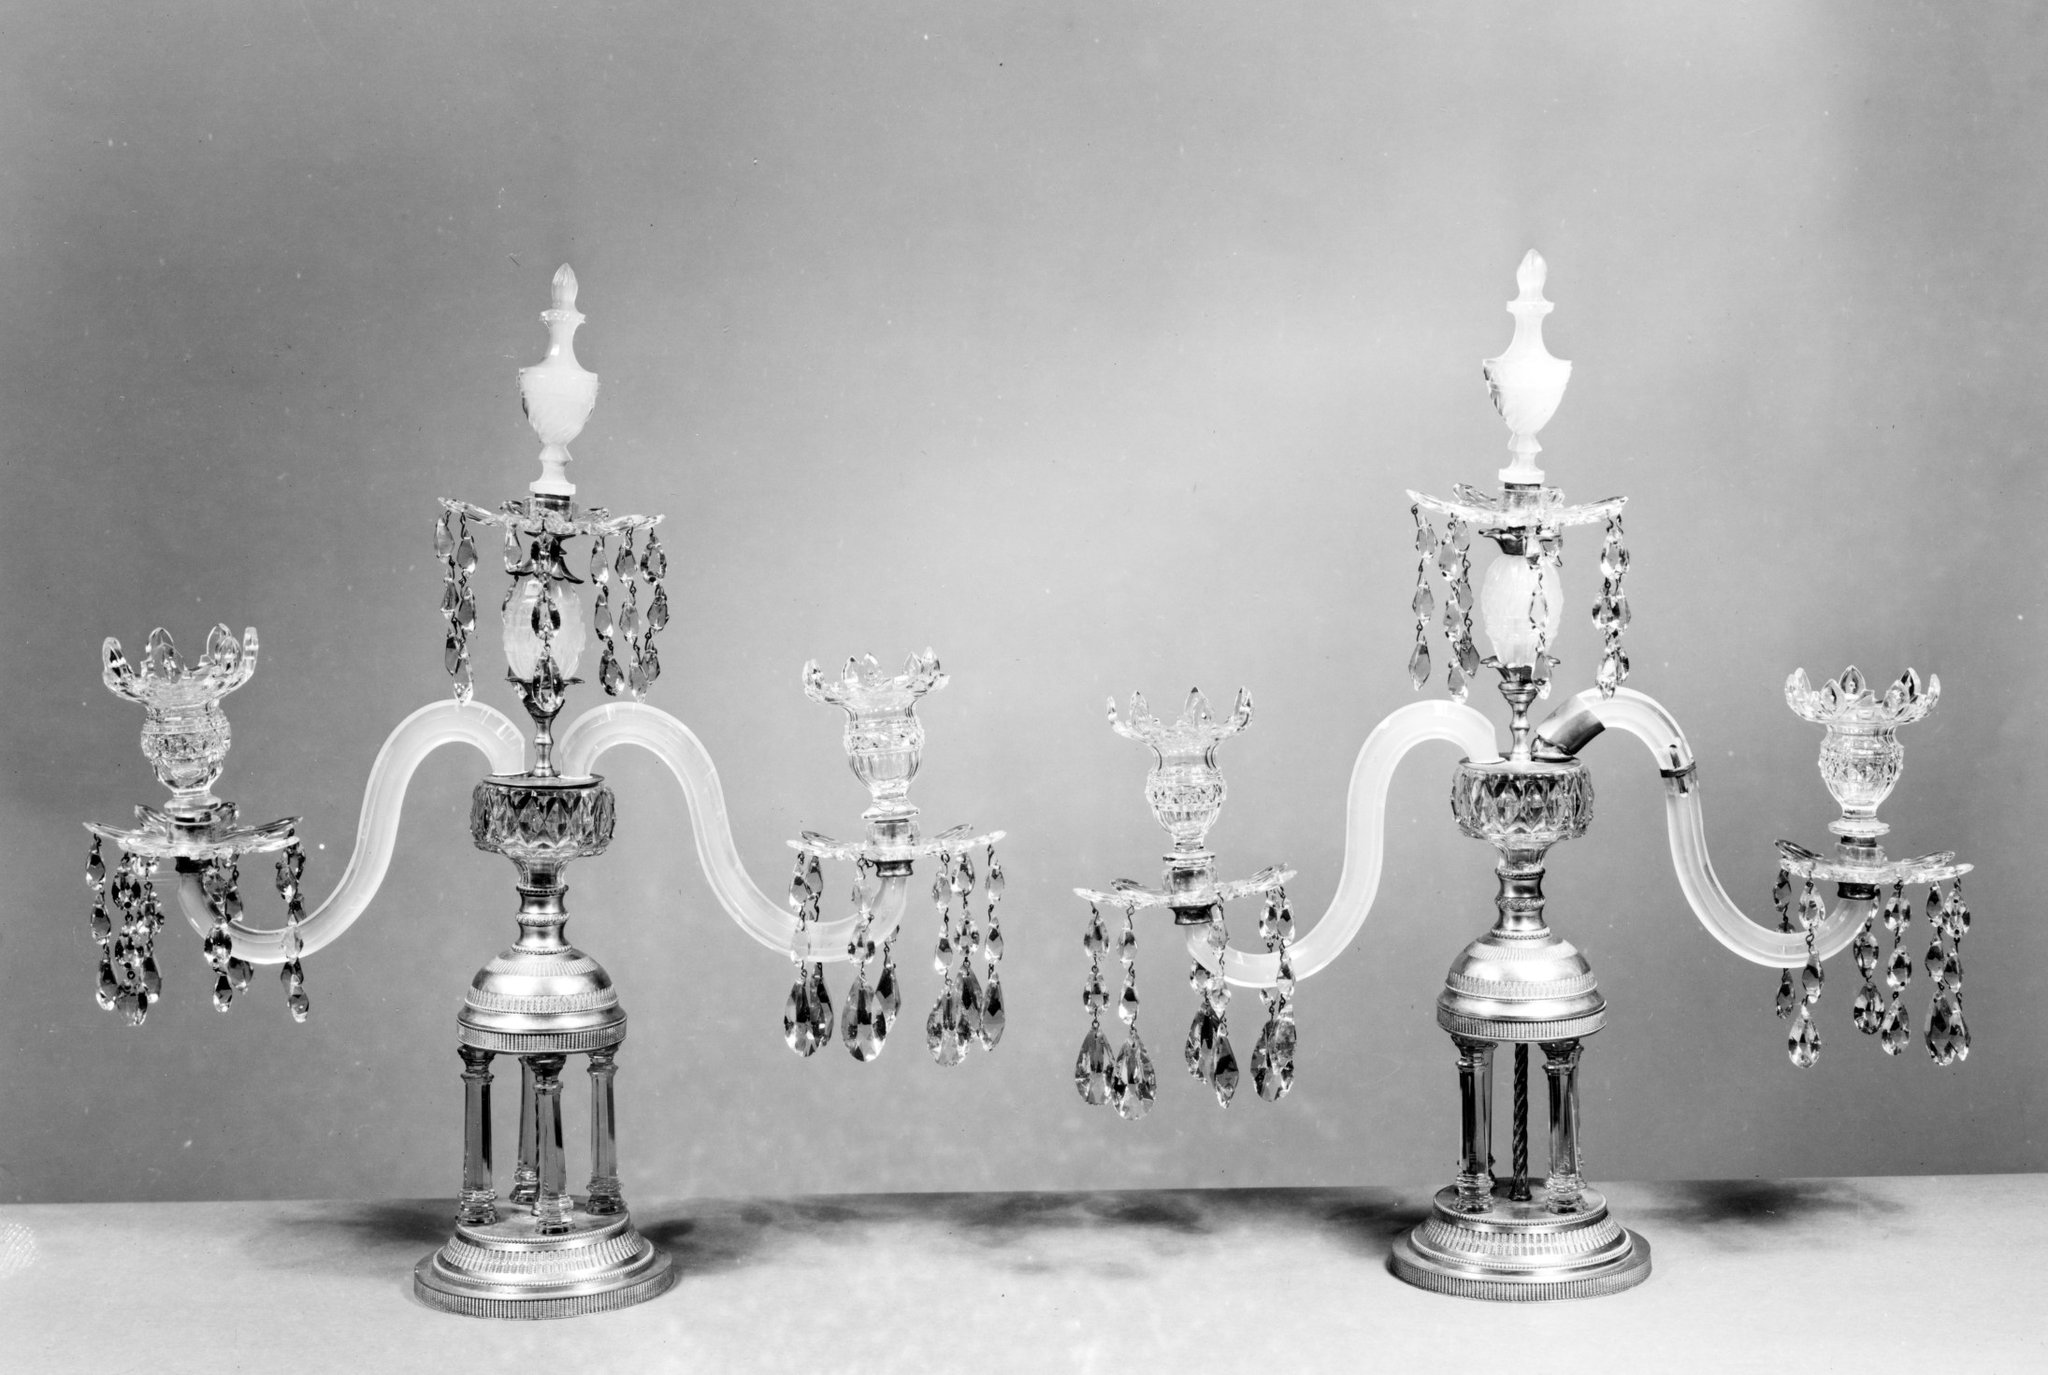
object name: candelabrum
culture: british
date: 1801-1900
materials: brass, glass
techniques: glassblowing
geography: england